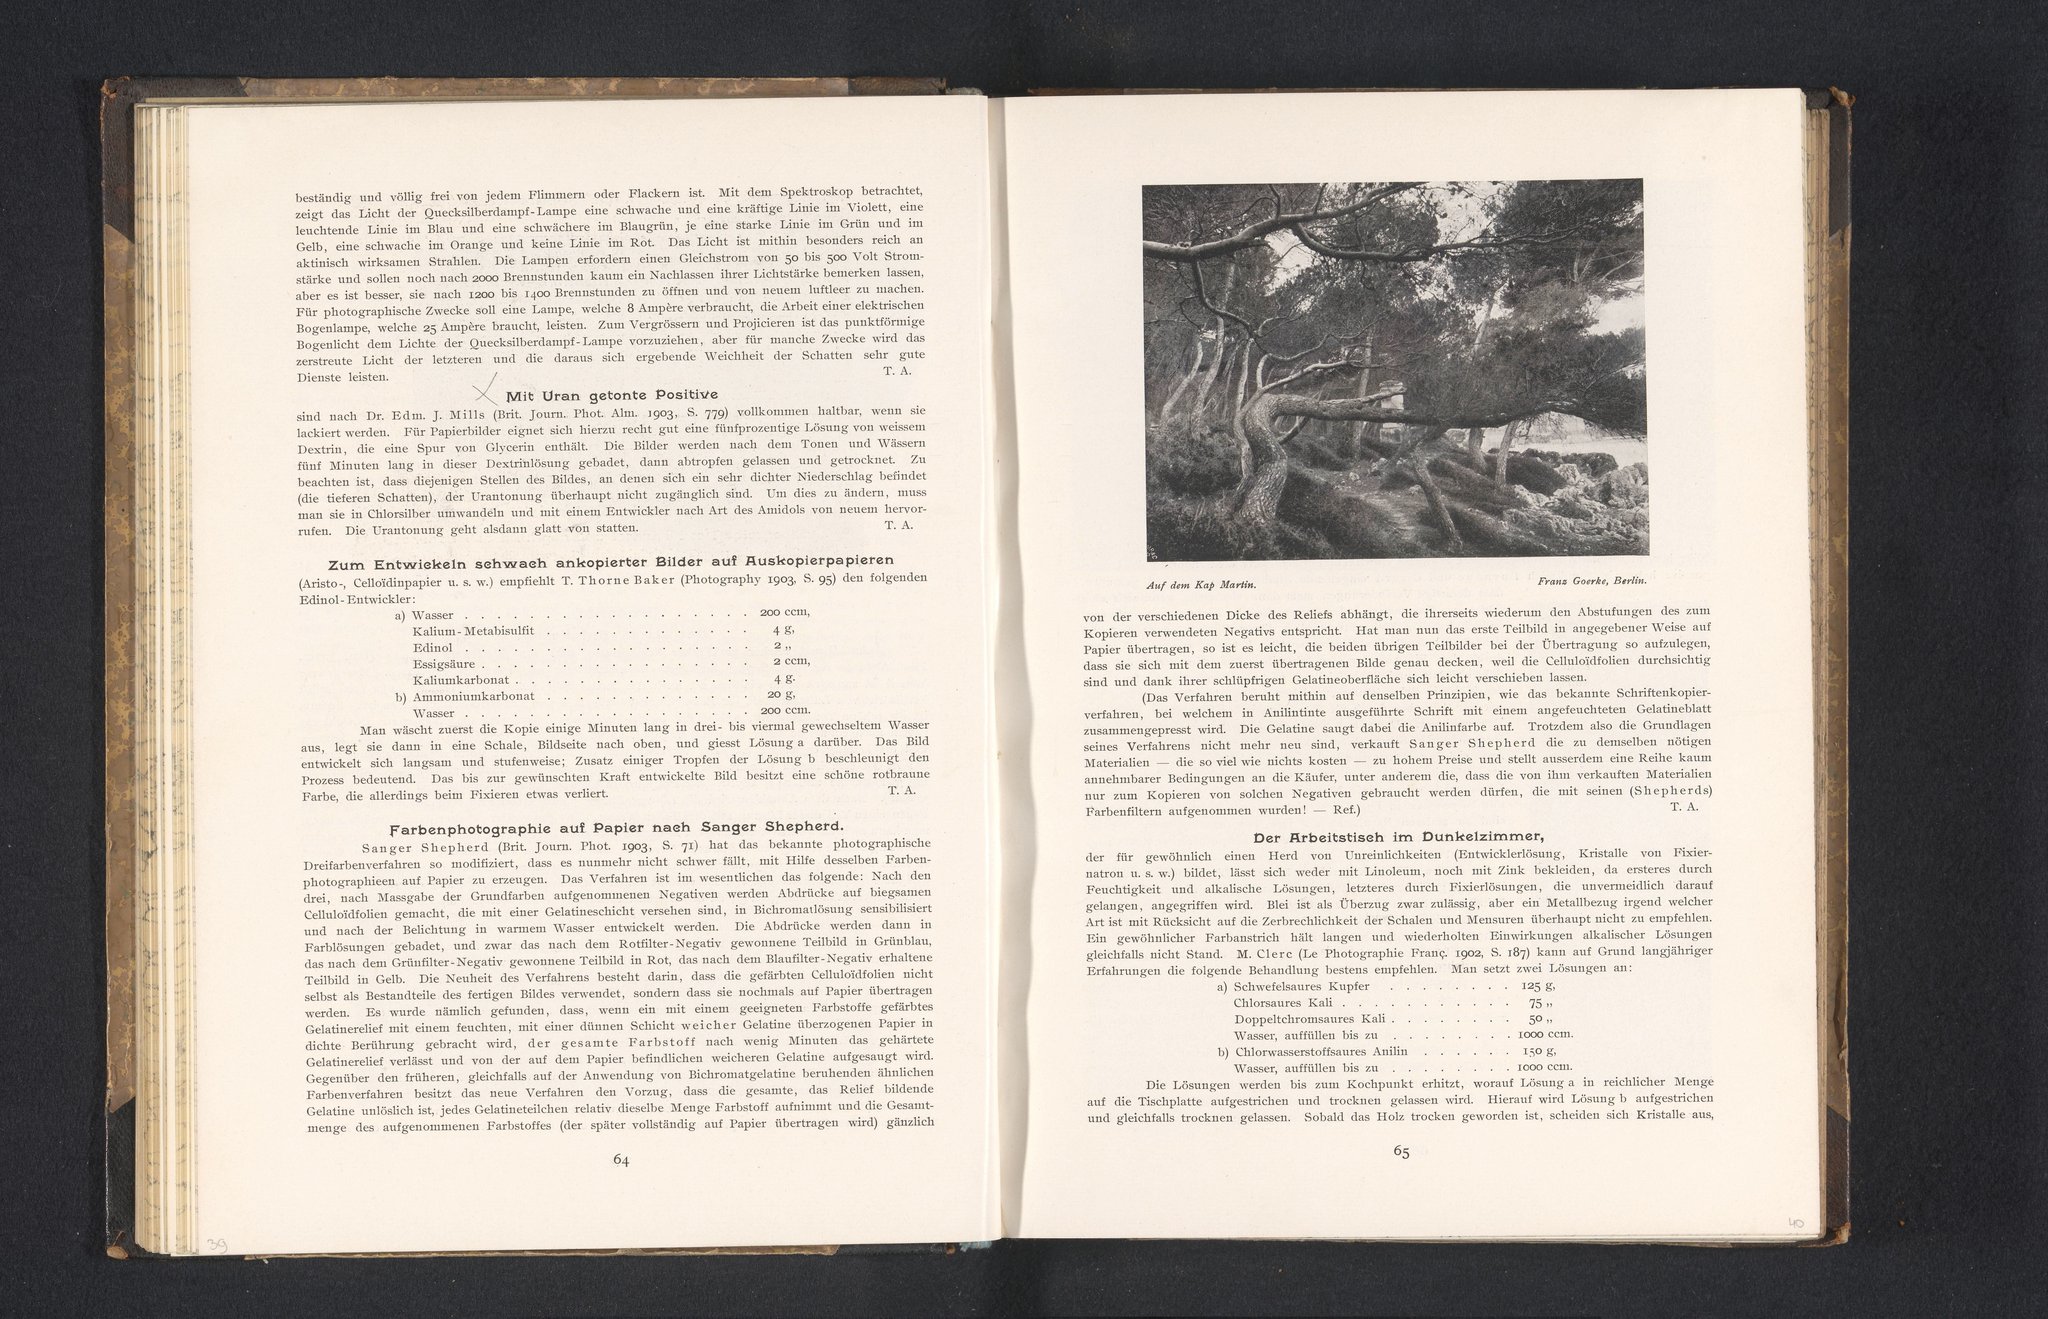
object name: photomechanical print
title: Auf dem Kap Martin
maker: franz goerke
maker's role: fotograaf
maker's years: 1856-1931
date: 1898-1903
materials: paper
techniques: autotype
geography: roquebrune-cap-martin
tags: forest, wood